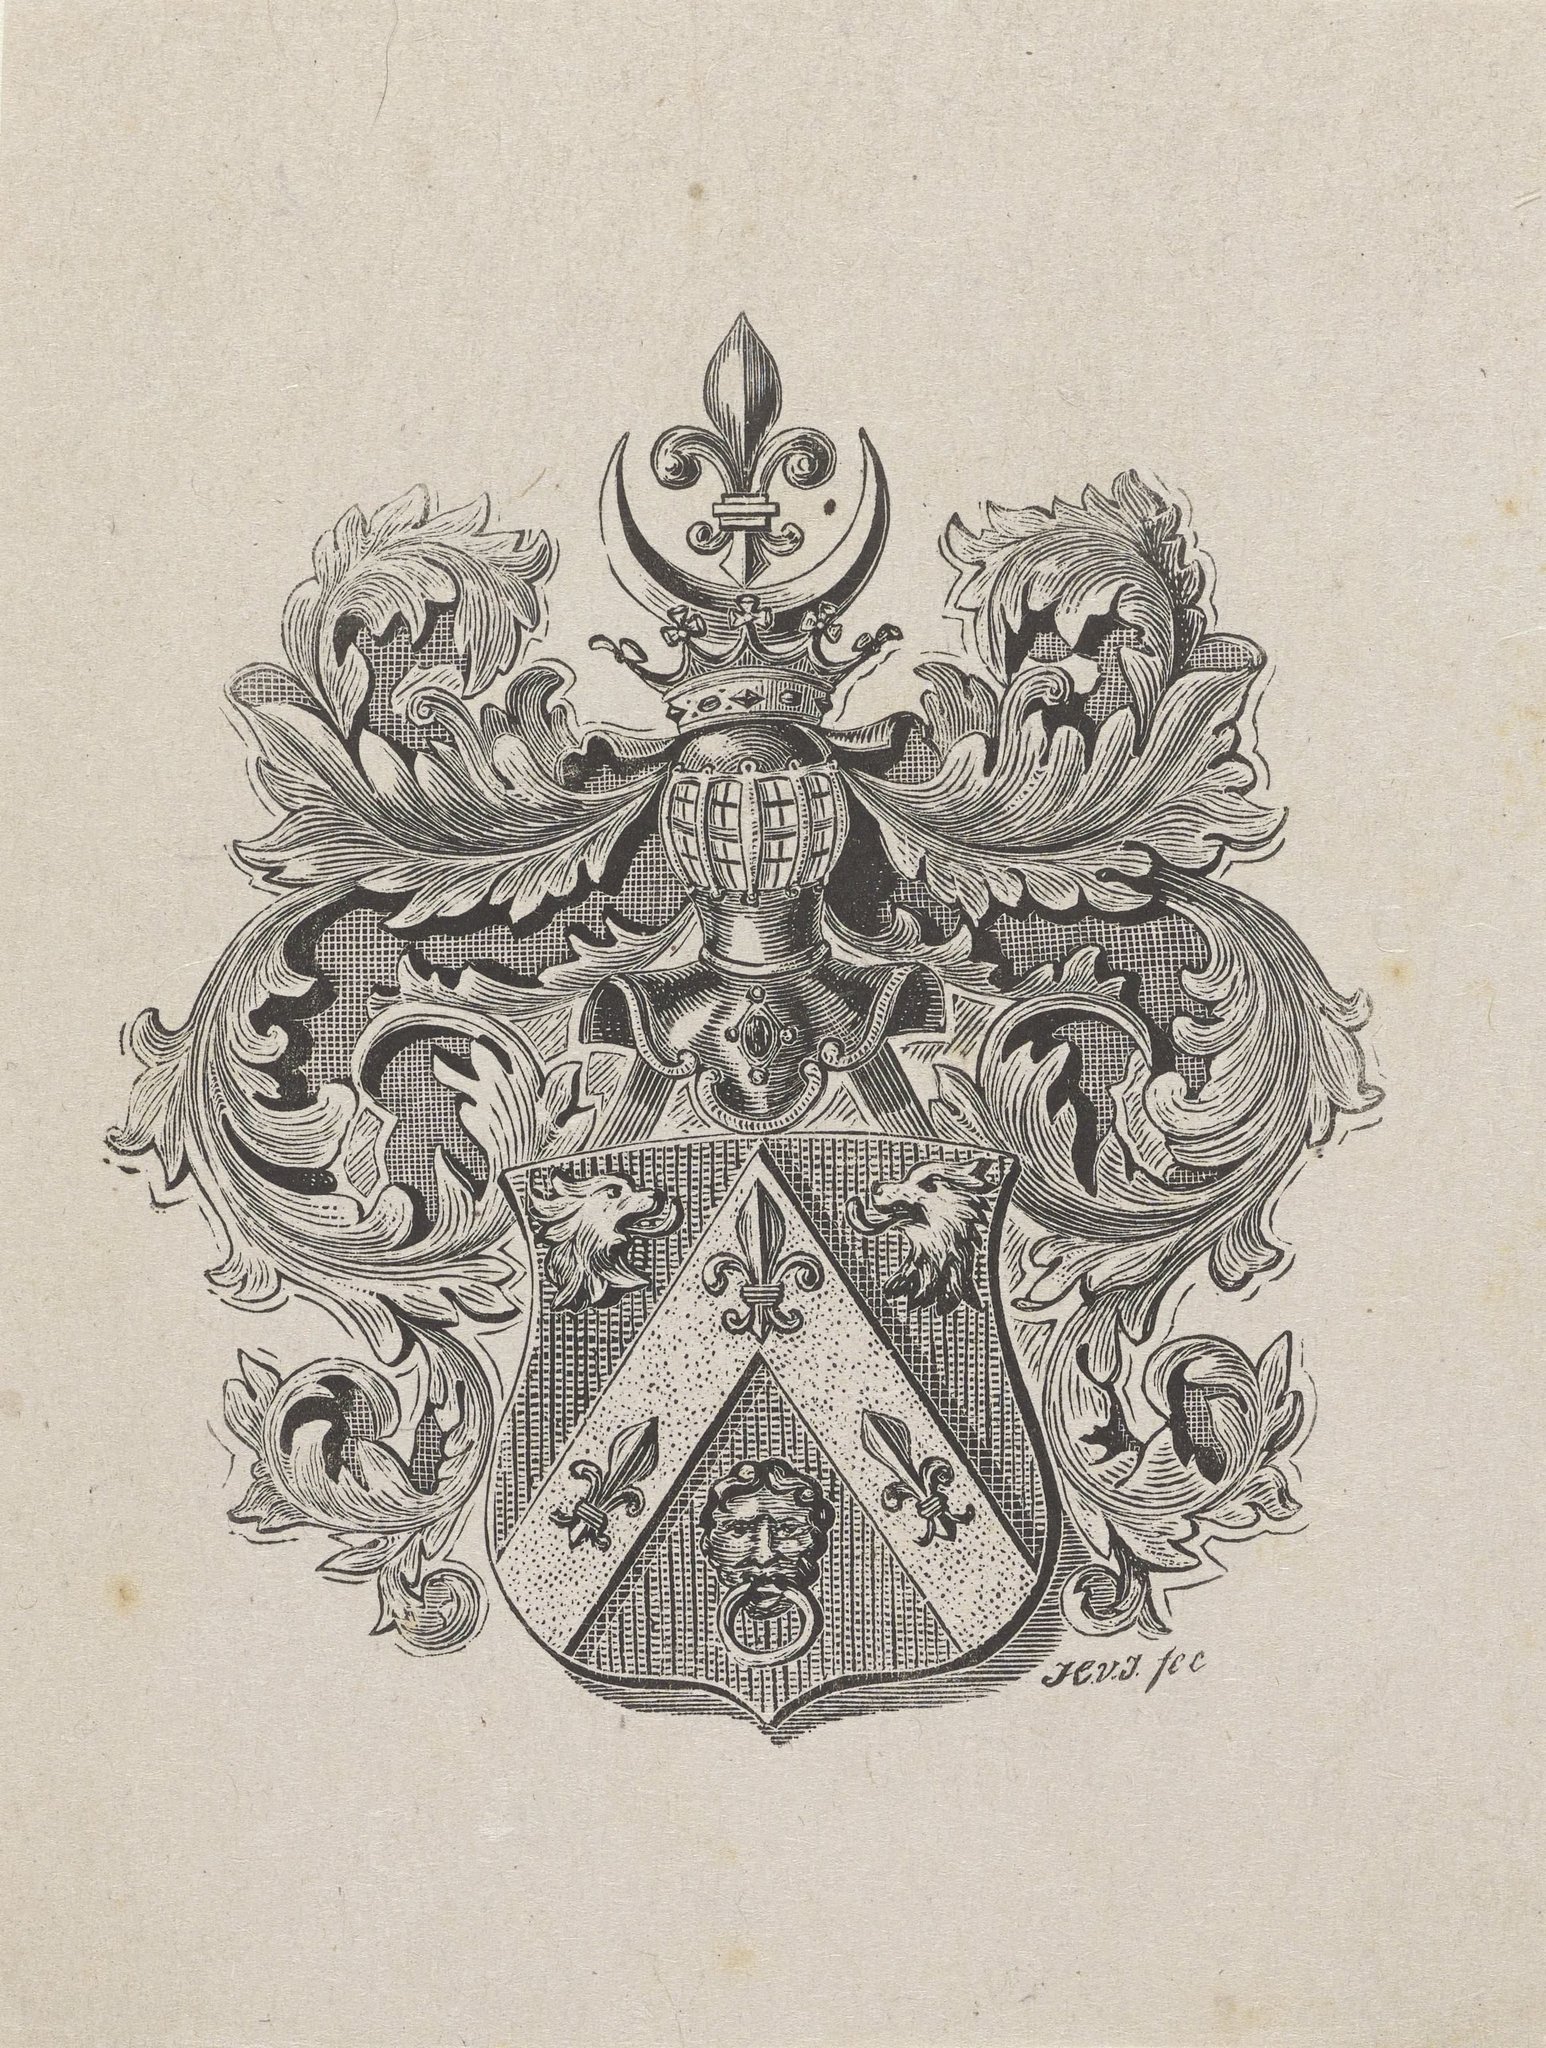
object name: print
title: Vignet met een wapen en een helm met een kroon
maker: isaac weissenbruch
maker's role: print maker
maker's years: 1826-1912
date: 1836-1912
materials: paper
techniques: engraving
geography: netherlands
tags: helmet, coat of arms (as symbol of the state, etc.), vignette